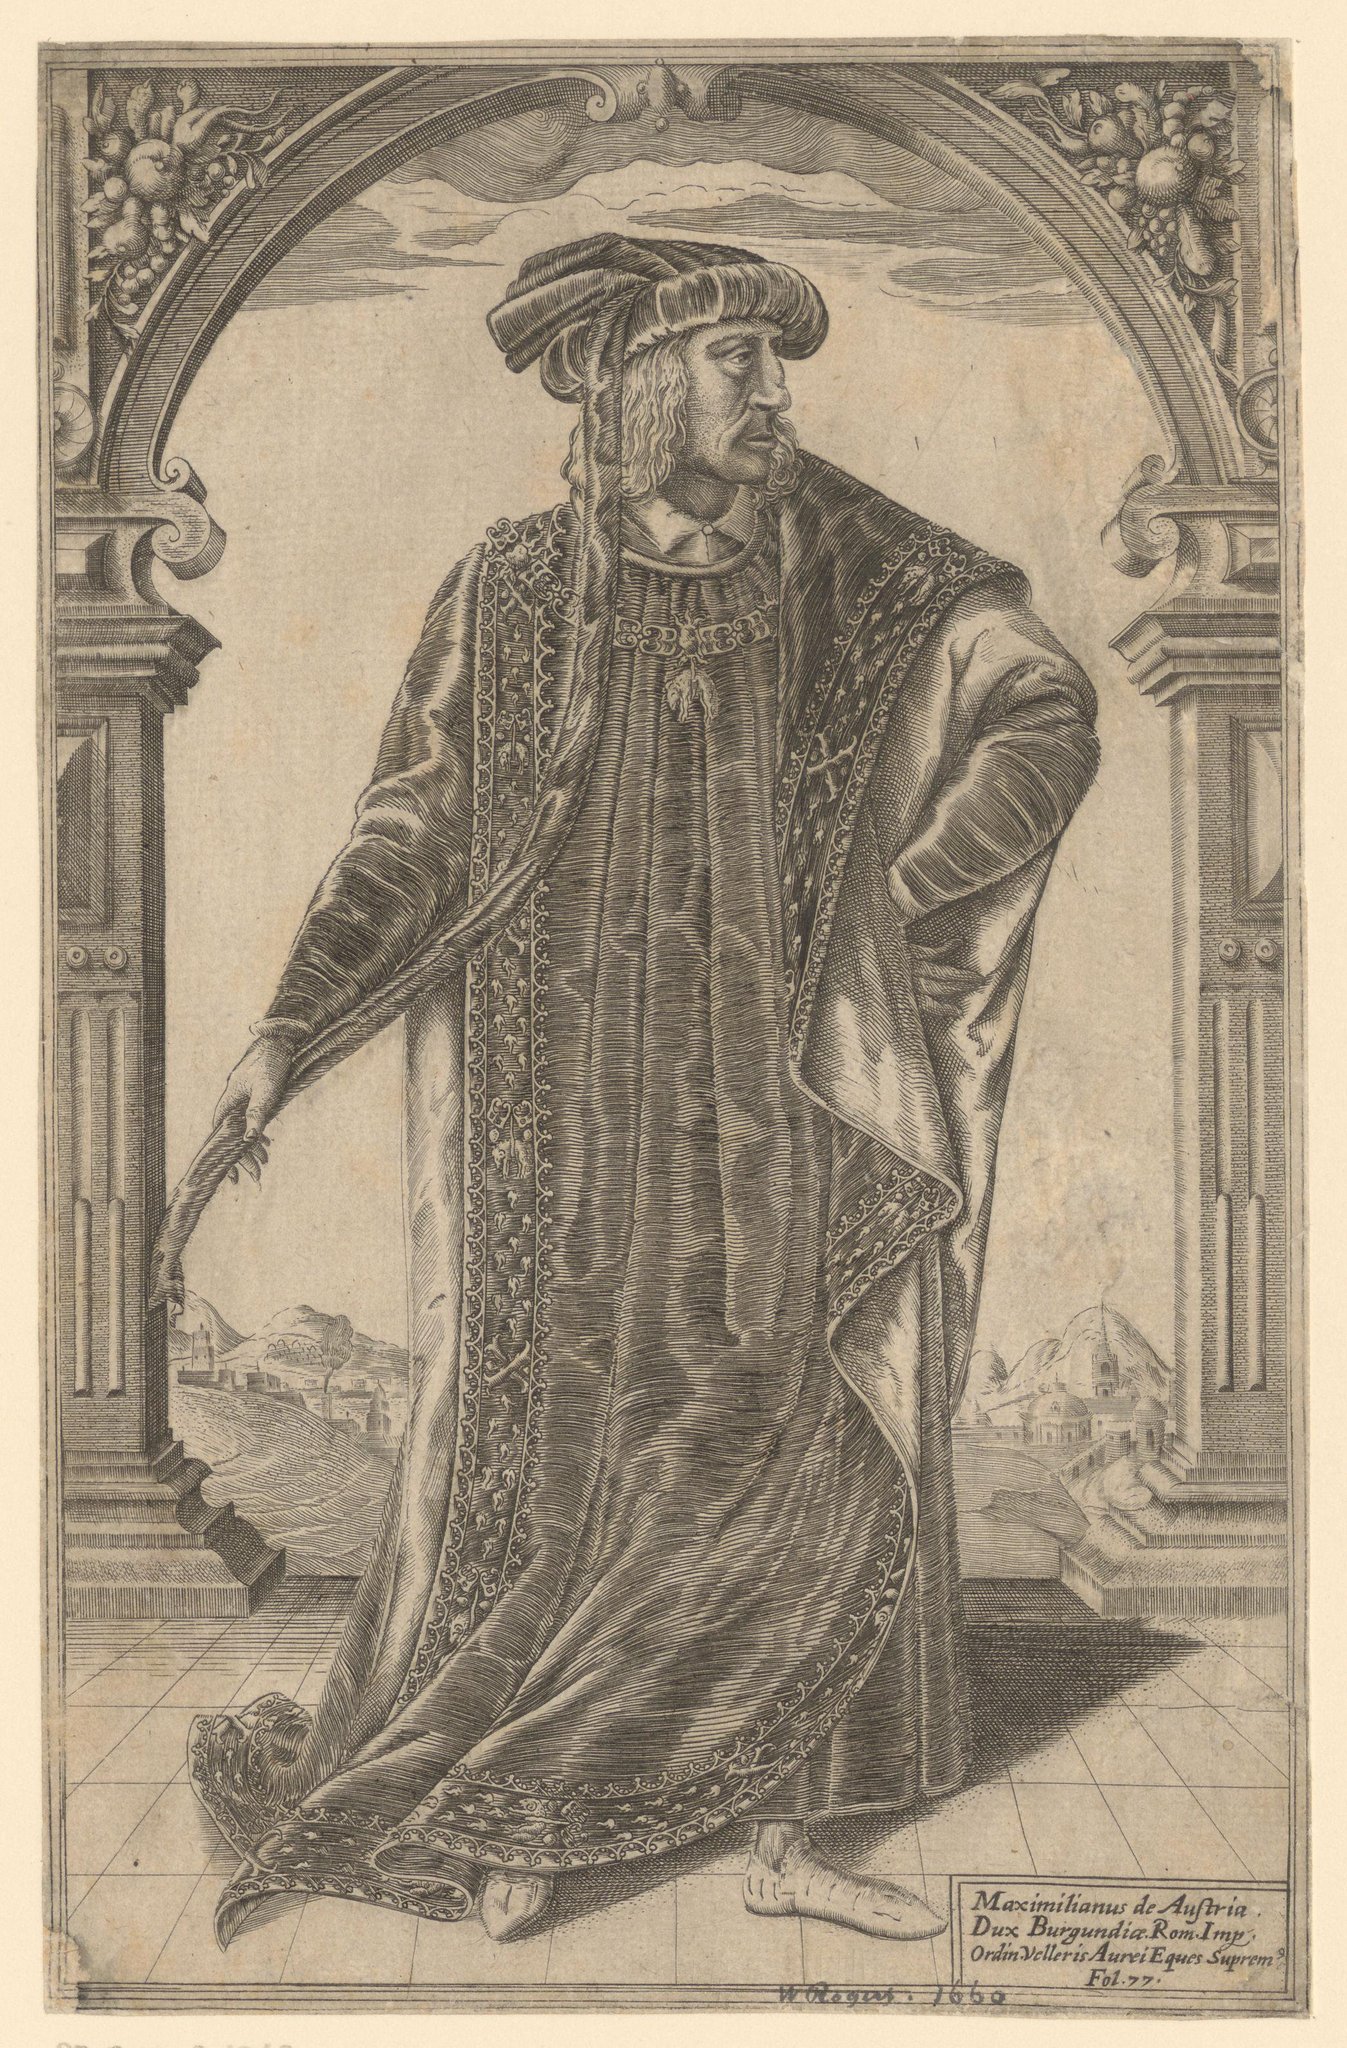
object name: print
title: Portret van keizer Maximiliaan I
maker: william rogers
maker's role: print maker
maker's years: 1545-1604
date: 1589-1602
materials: paper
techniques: engraving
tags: maximilian i (holy roman emperor), historical persons, knighthood order of the golden fleece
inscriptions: collector's mark: Lugt 2228, annotation: ‘W.Rogers 1660’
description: Prent gebruikt in: Segar, William. Honor Military, and Civill. Londen: Robert Barker, 1602.